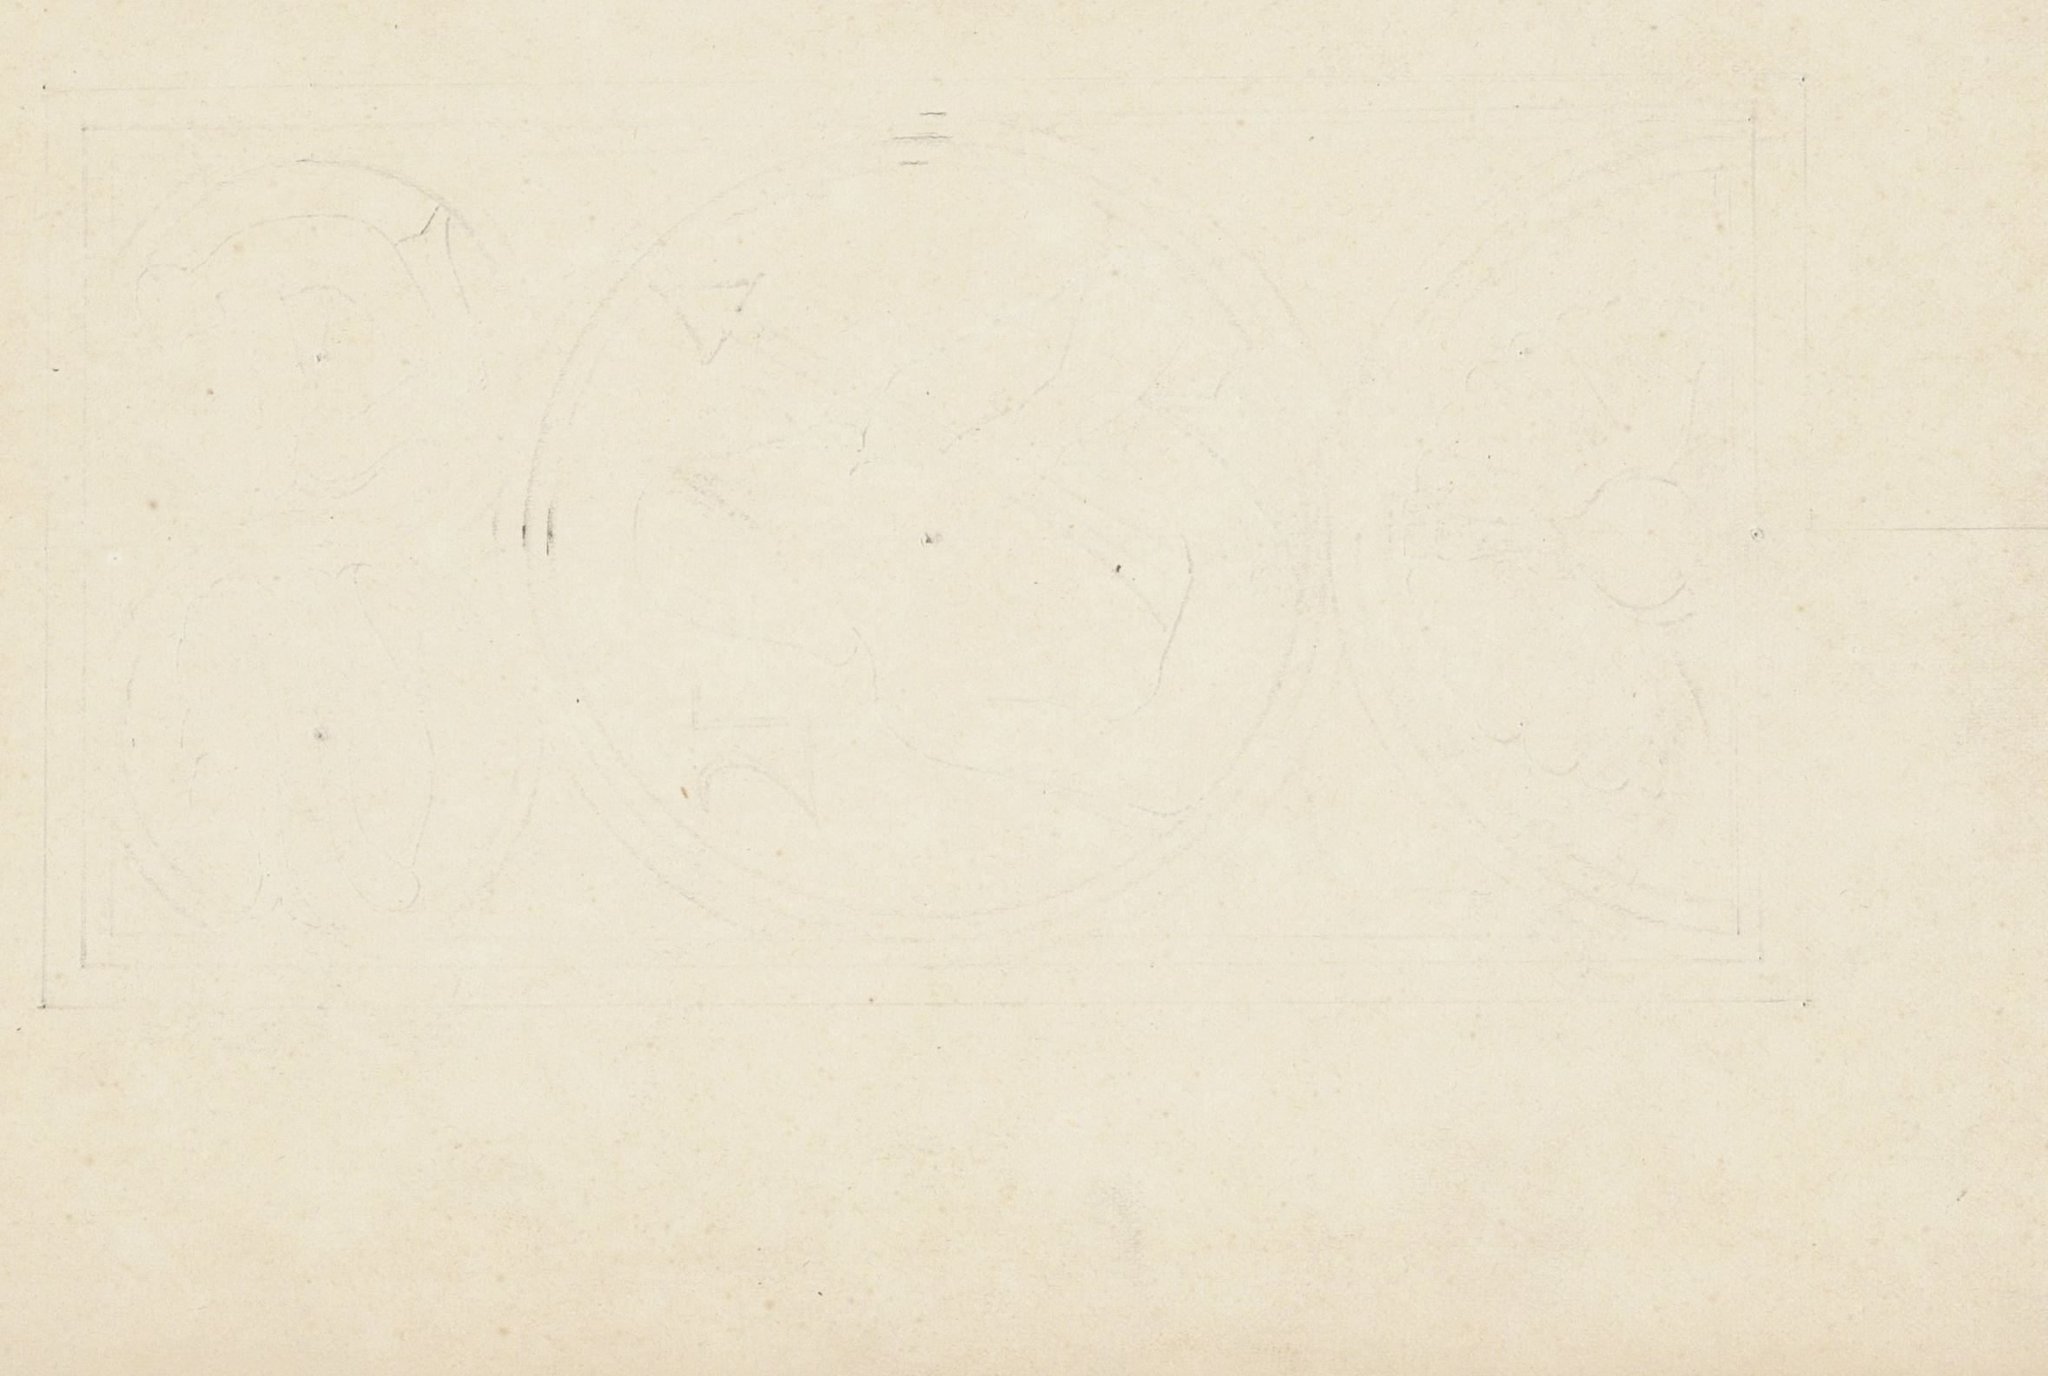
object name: sketchbook leaf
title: Medaillons in een rechthoek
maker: antoon derkinderen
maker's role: draughtsman, painter, print maker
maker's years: 1859-1925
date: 1900-1903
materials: paper, pencil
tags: window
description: Vermoedelijk een ontwerp voor een glas-in-loodraam voor de Kamer van Koophandel in de Beurs van Berlage te Amsterdam. Blad 2 recto uit een schetsboek met 45 bladen.